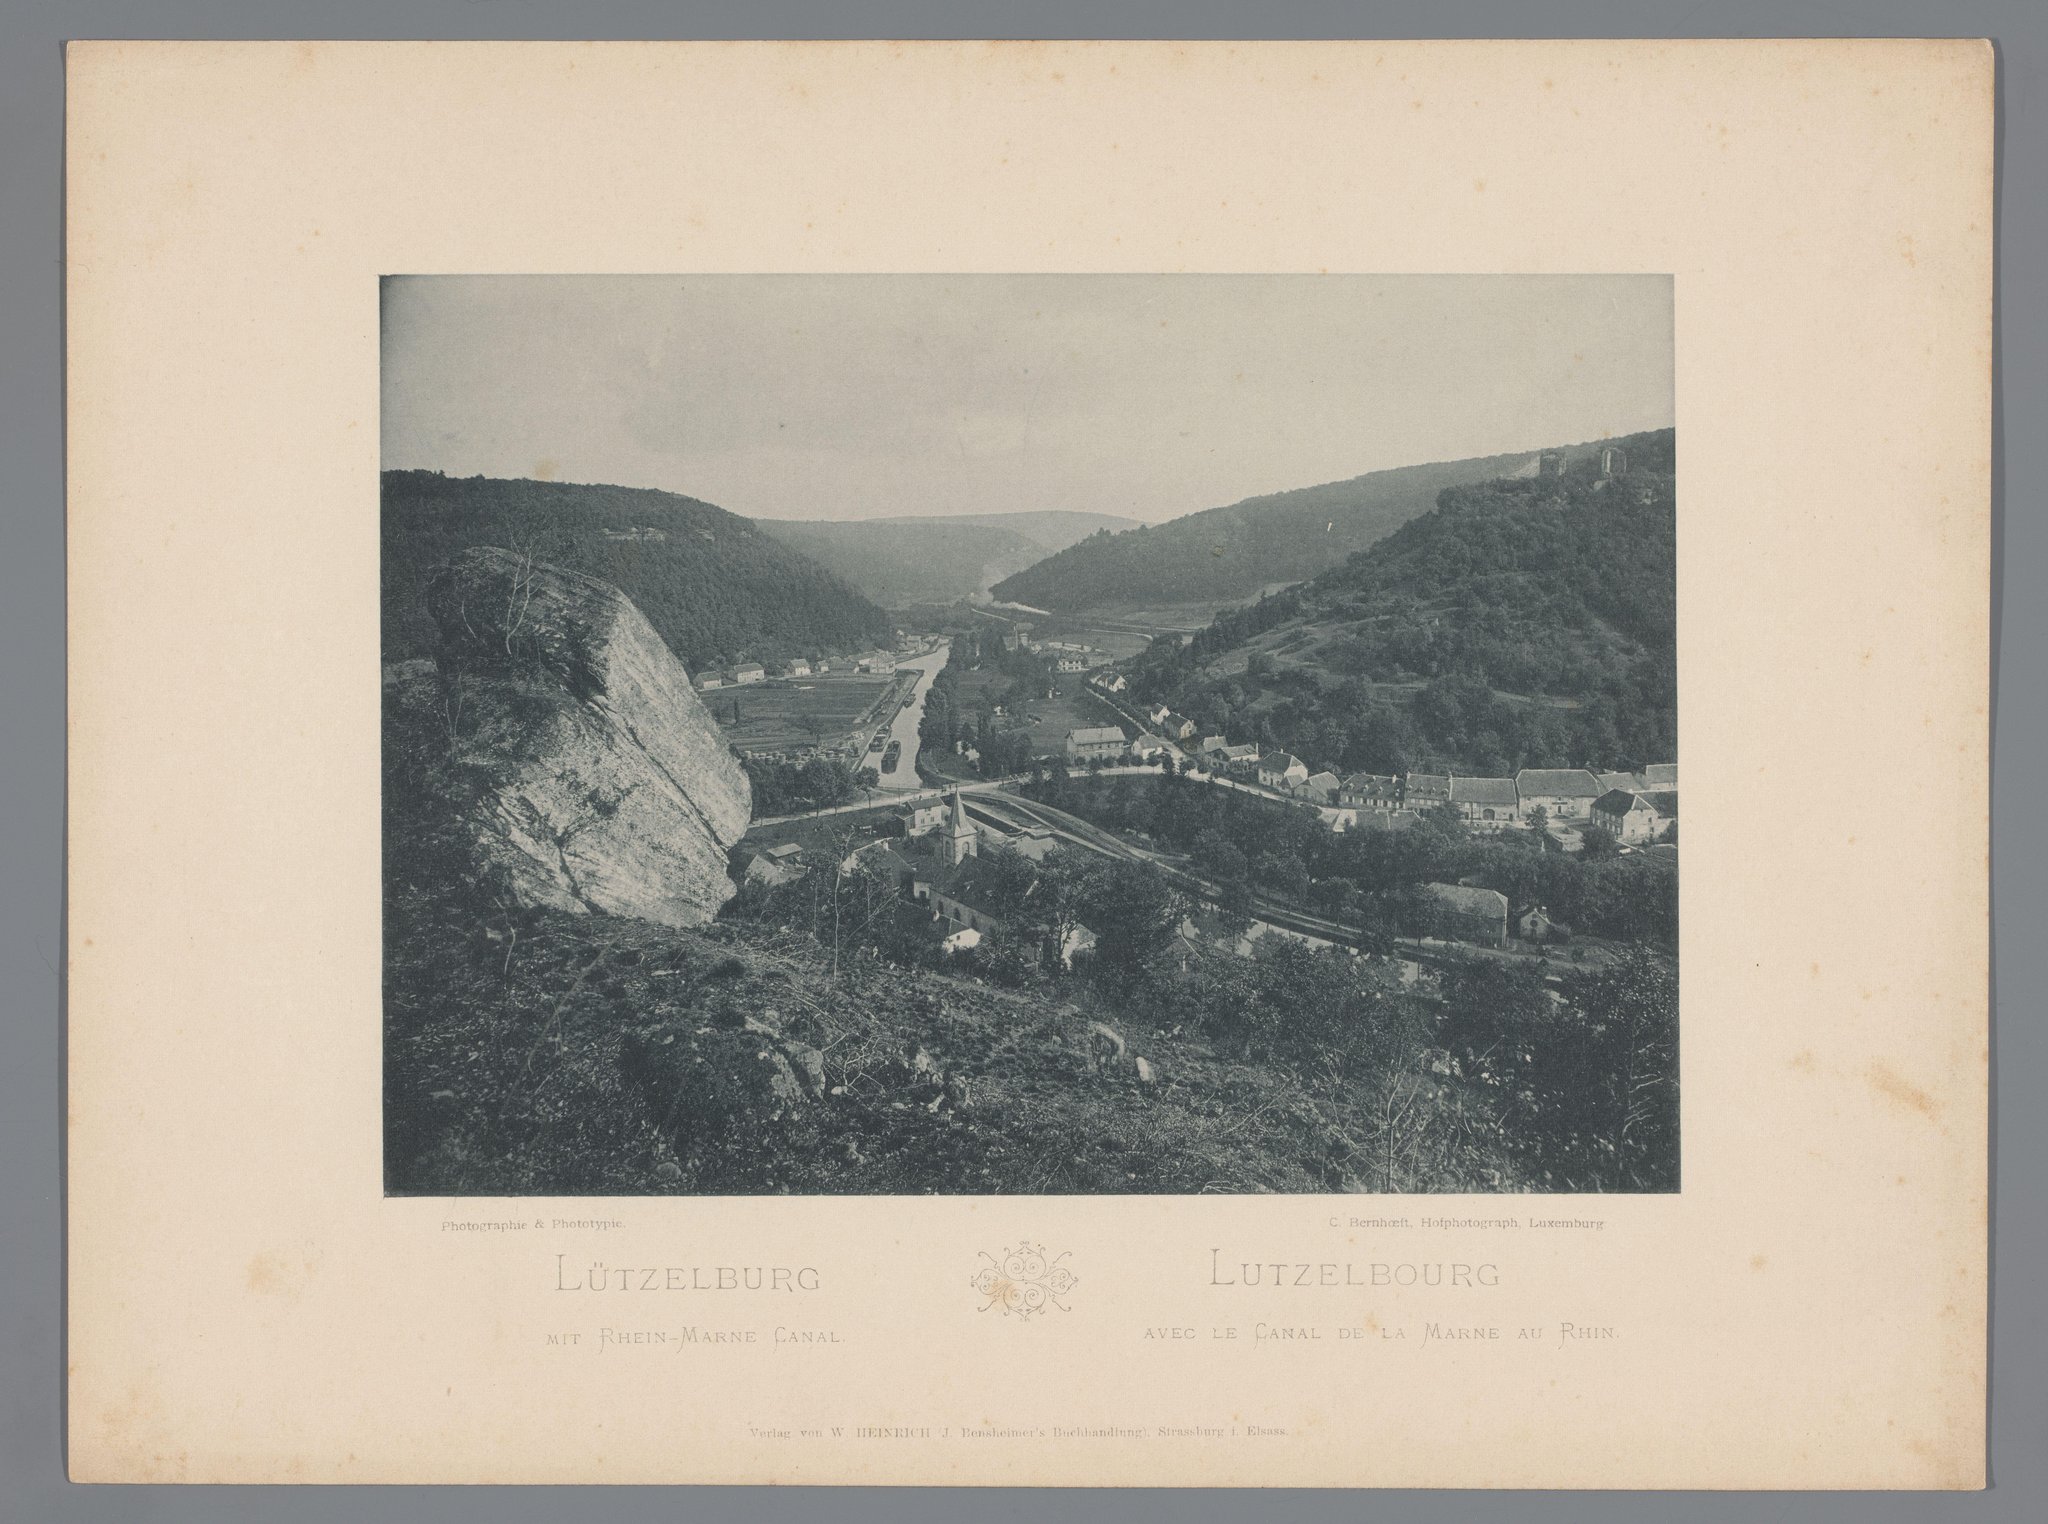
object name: photomechanical print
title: Gezicht op Lutzelbourg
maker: charles bernhoeft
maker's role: publisher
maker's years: 1859-1933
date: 1889-1894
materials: paper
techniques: photograph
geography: luxembourg city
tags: village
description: Deze prent maakt deel uit van een omslag met 100 prenten.